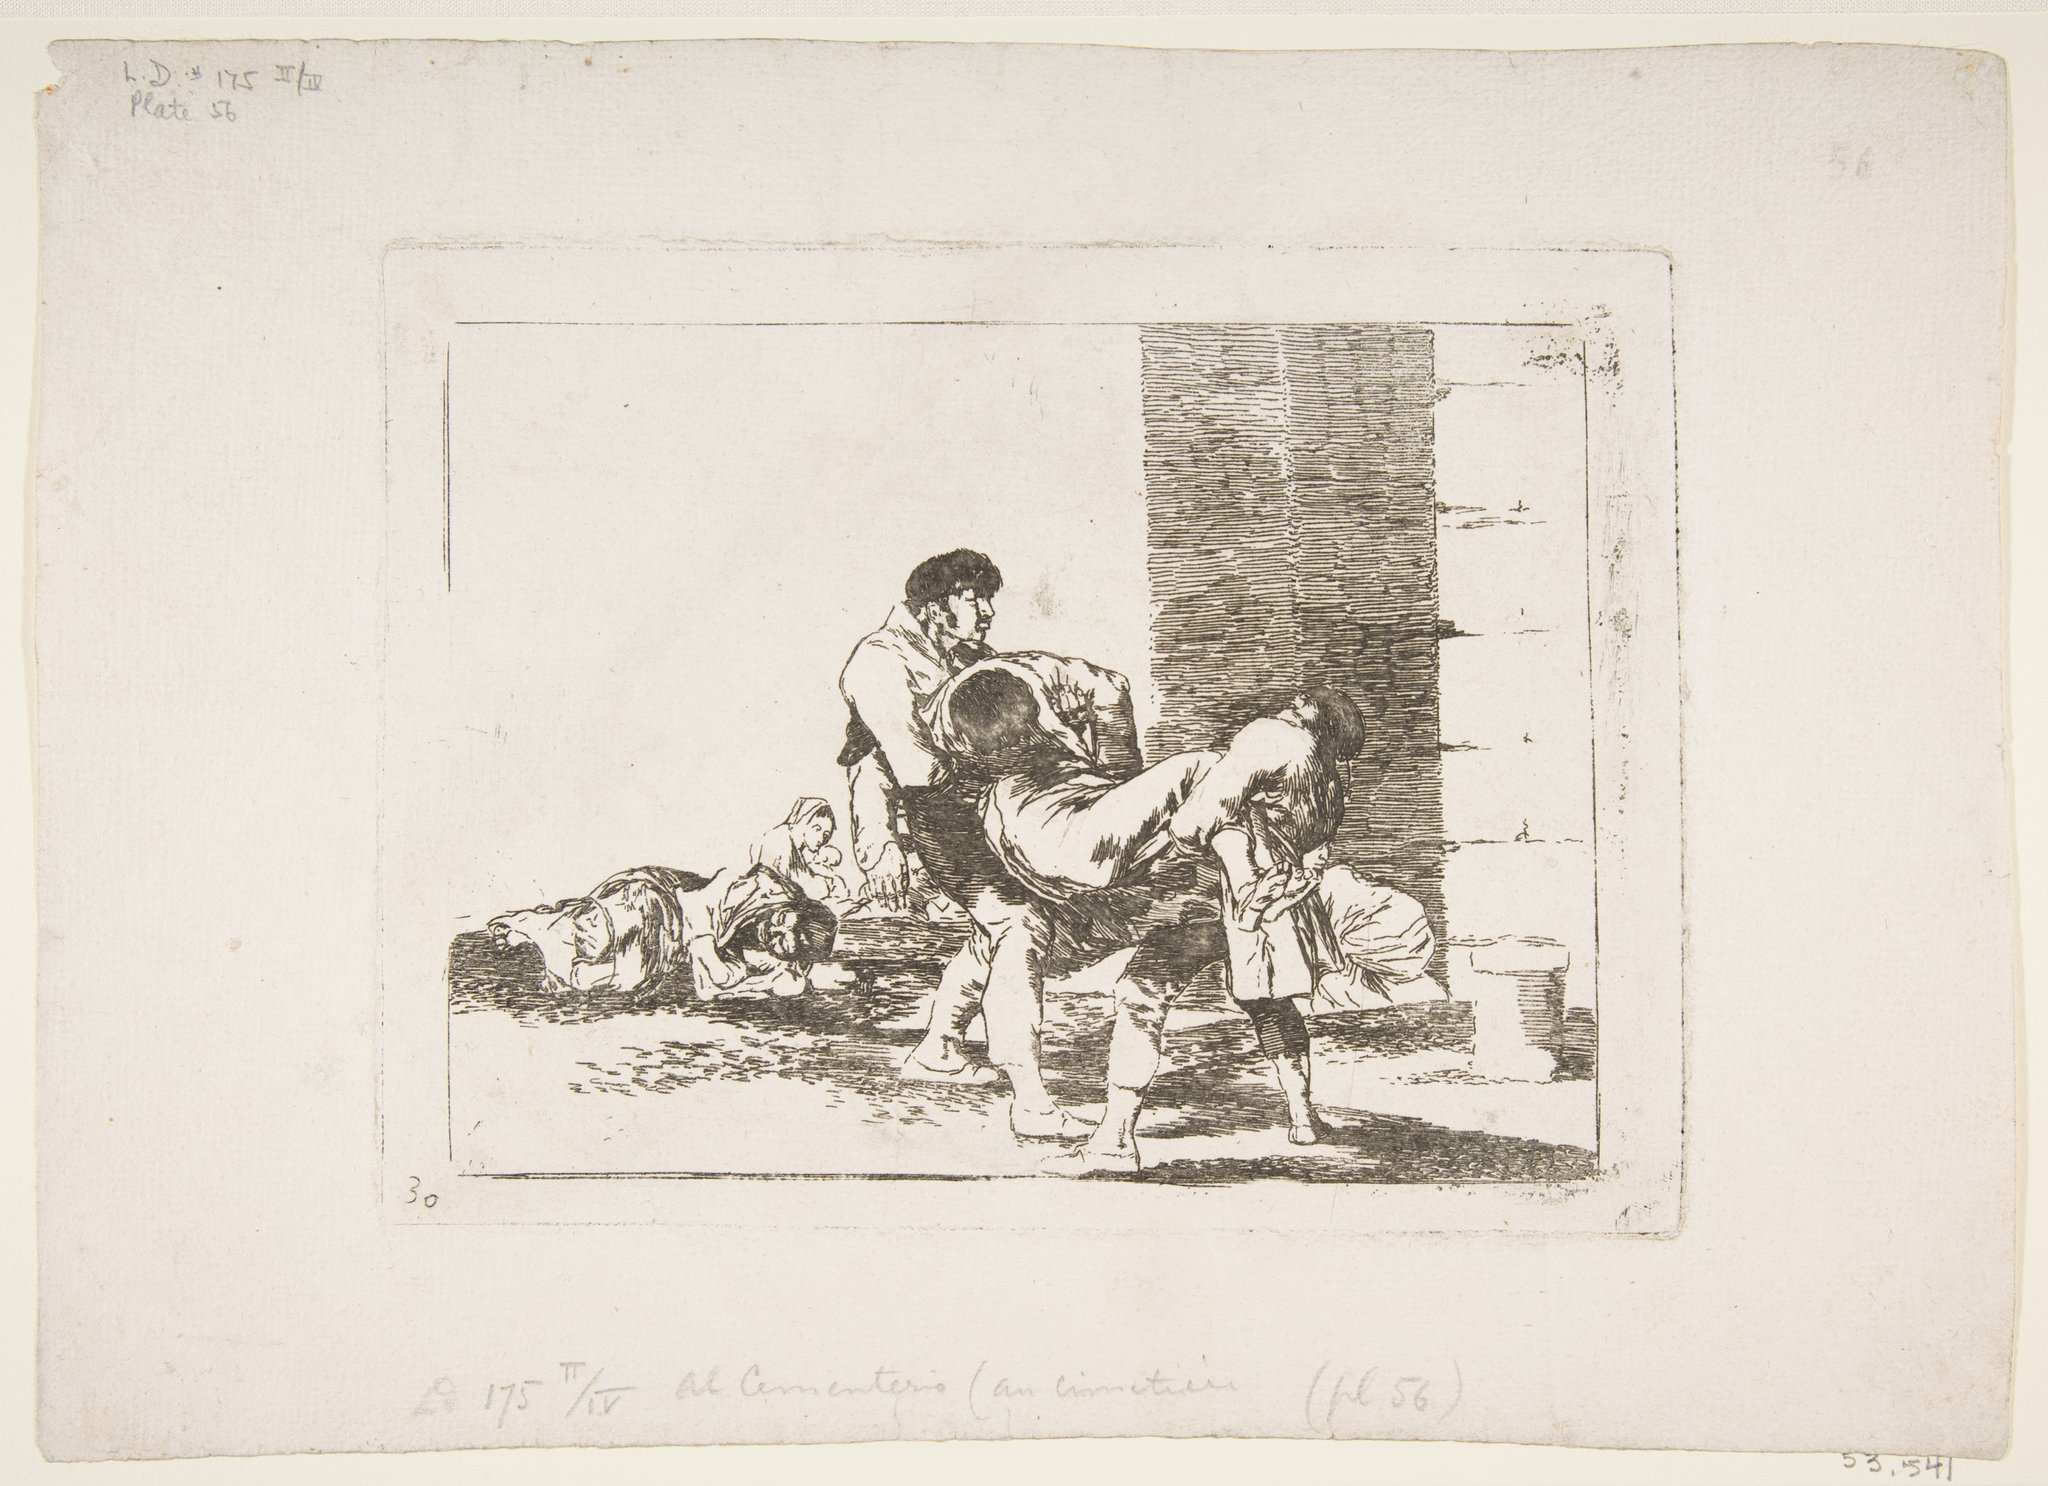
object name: print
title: Plate 56, To the cemetery (Al cementerio), from "The Disasters of War" (Los Desastres de la Guerra)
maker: goya (francisco de goya y lucientes)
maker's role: artist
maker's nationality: spanish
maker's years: 1746-1828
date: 1810-1811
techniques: drypoint, etching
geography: spain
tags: corpses,men,death